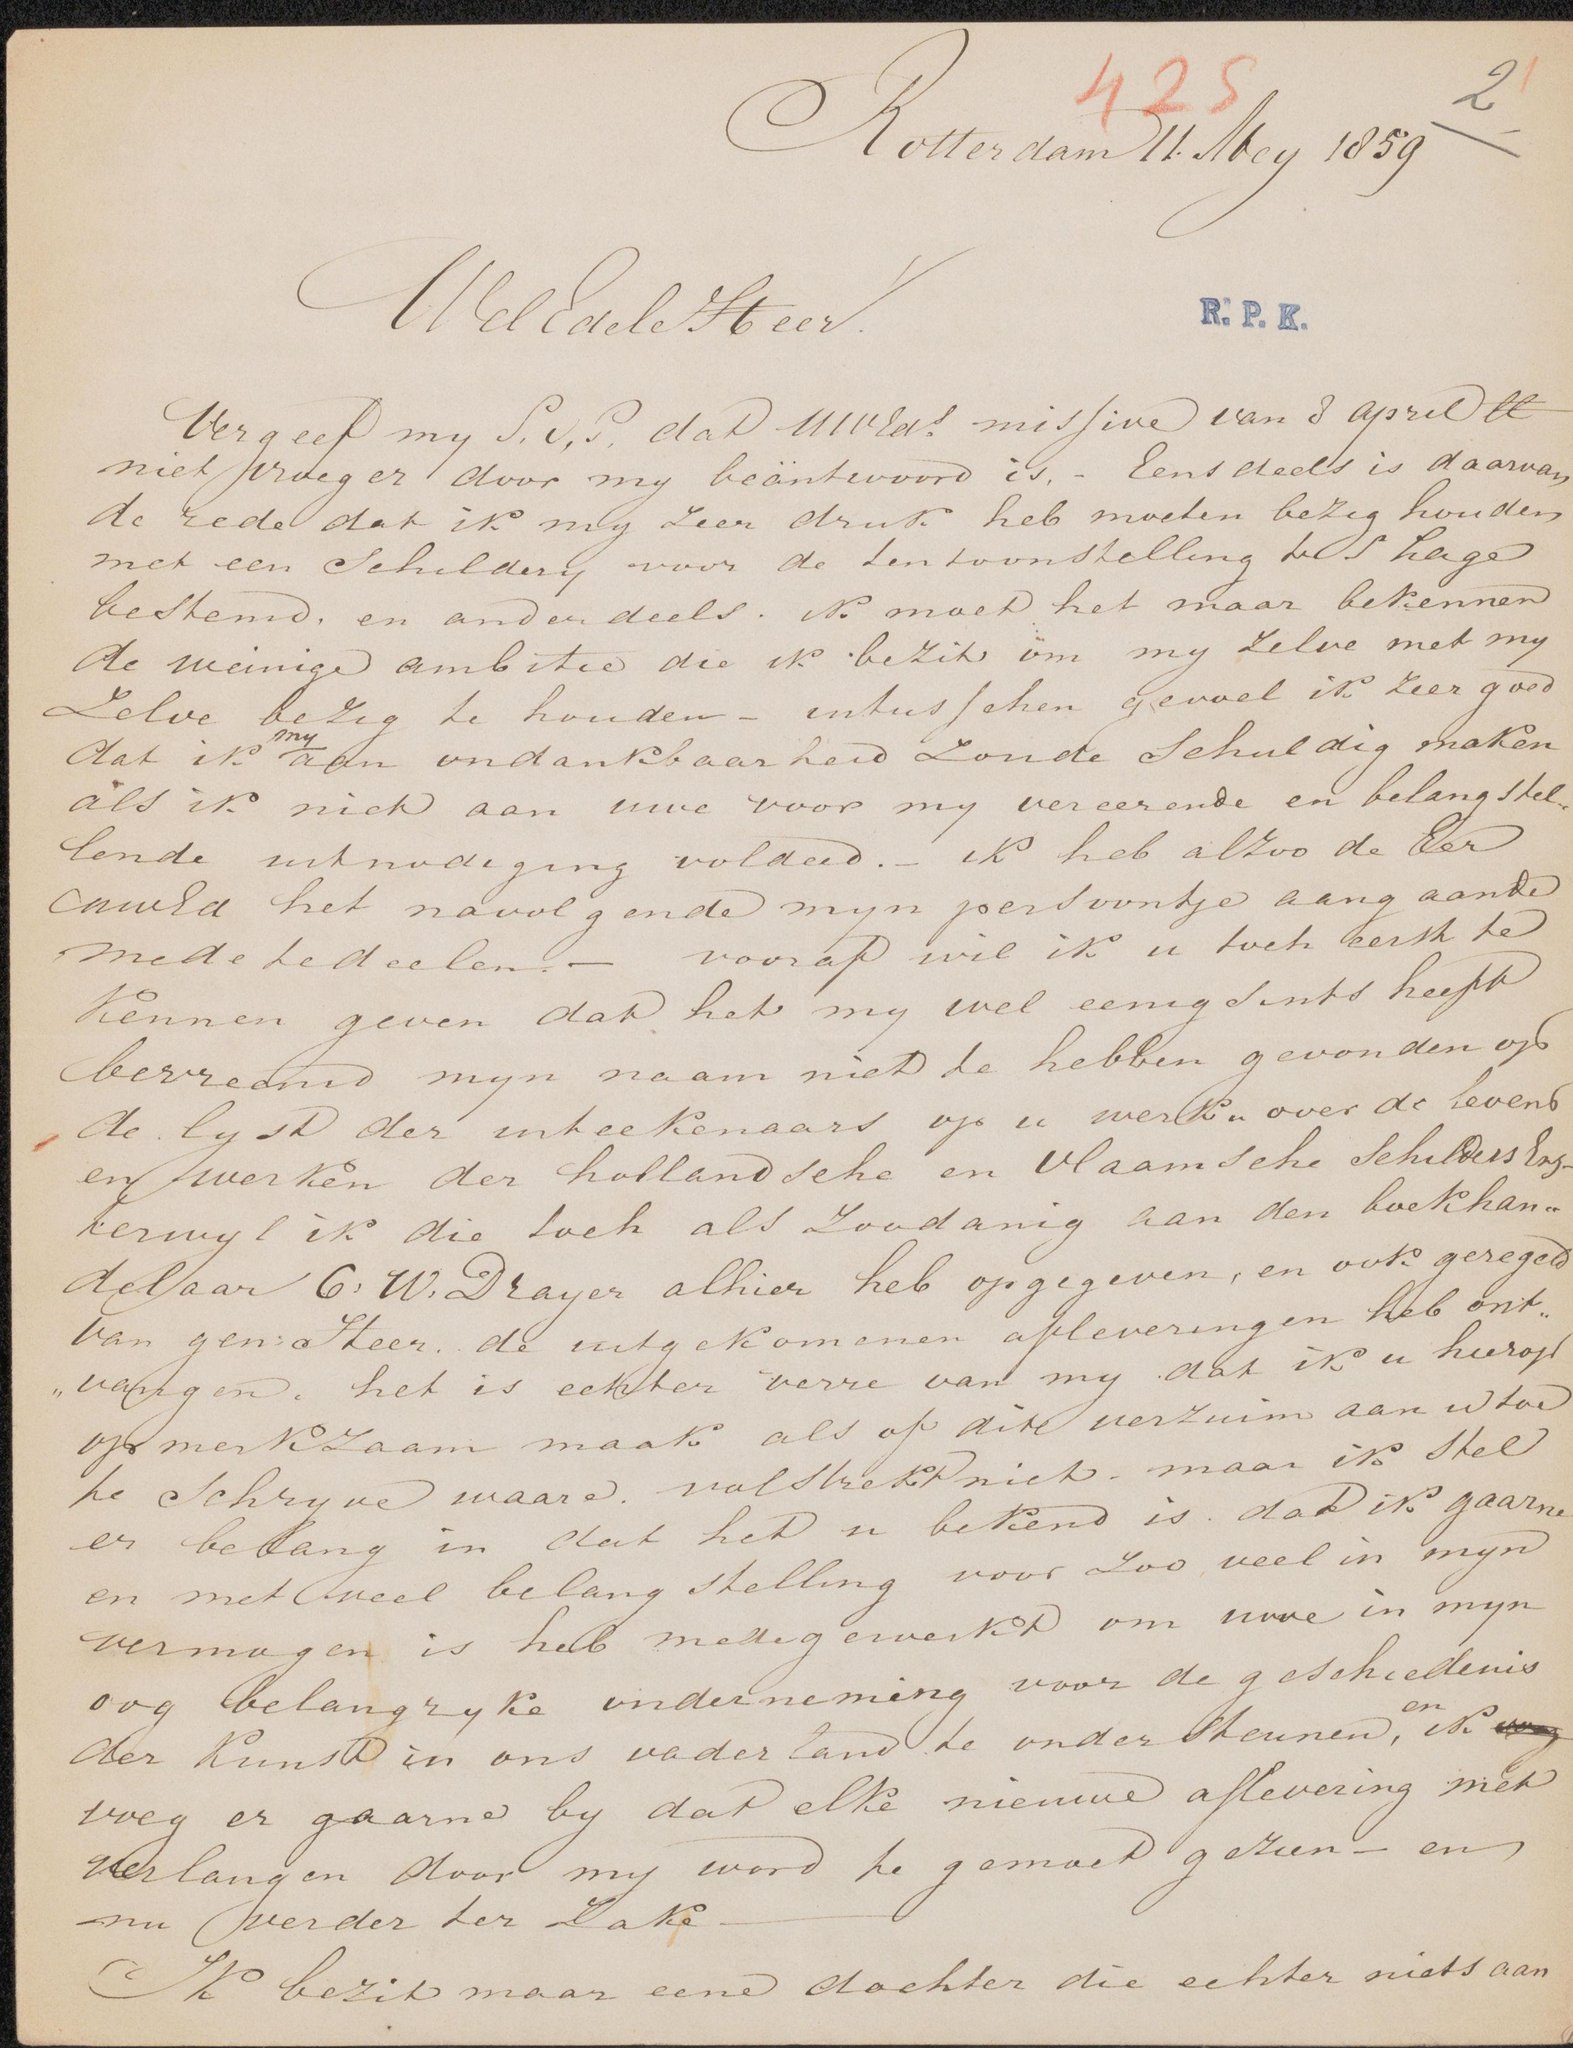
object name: letter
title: Brief aan Christiaan Kramm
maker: jan hendrik van de laar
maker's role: draughtsman, print maker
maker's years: 1807-1874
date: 1859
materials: ink, paper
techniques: pen, writing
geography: rotterdam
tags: hendrik tollens, willem hendrik schmidt, utrecht, print maker, draughtsman, christiaan kramm, literature ~ arts, family life, education, tuition of the artist (in general), painting (including book-illumination, miniature-painting), exhibition ~ art, diseases, the hague, antwerp, rotterdam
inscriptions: collector's mark: Lugt 2233